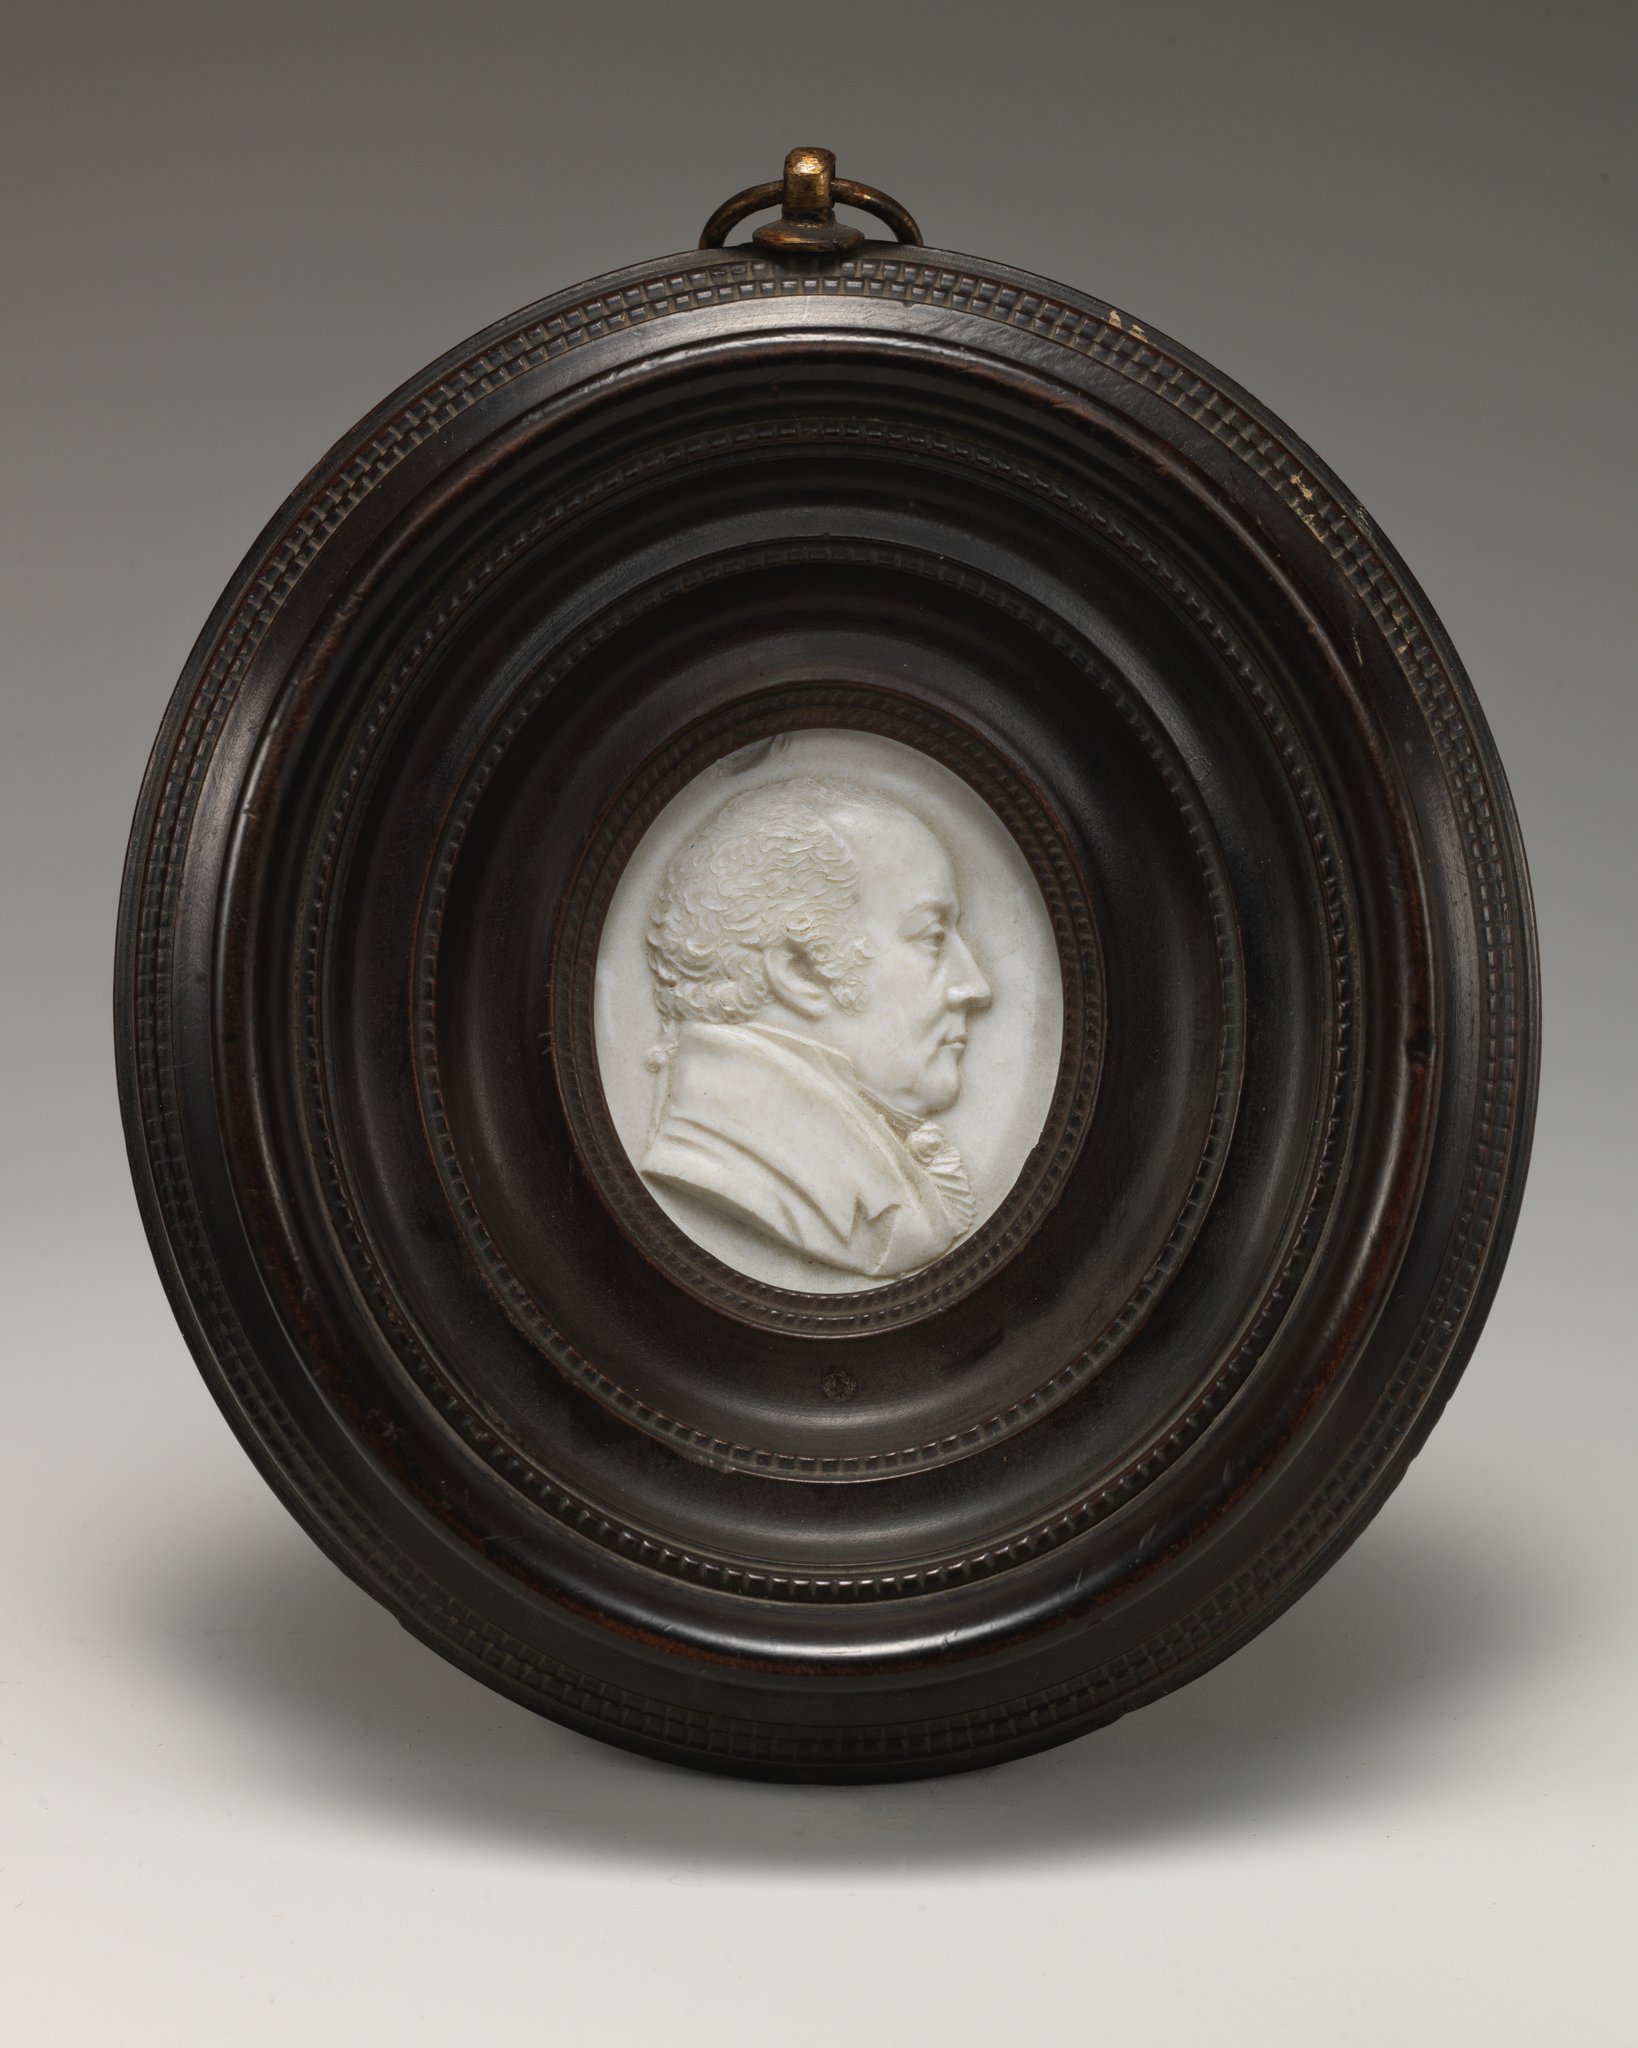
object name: medallion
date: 1767-1800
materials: glass, paste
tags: men,profiles